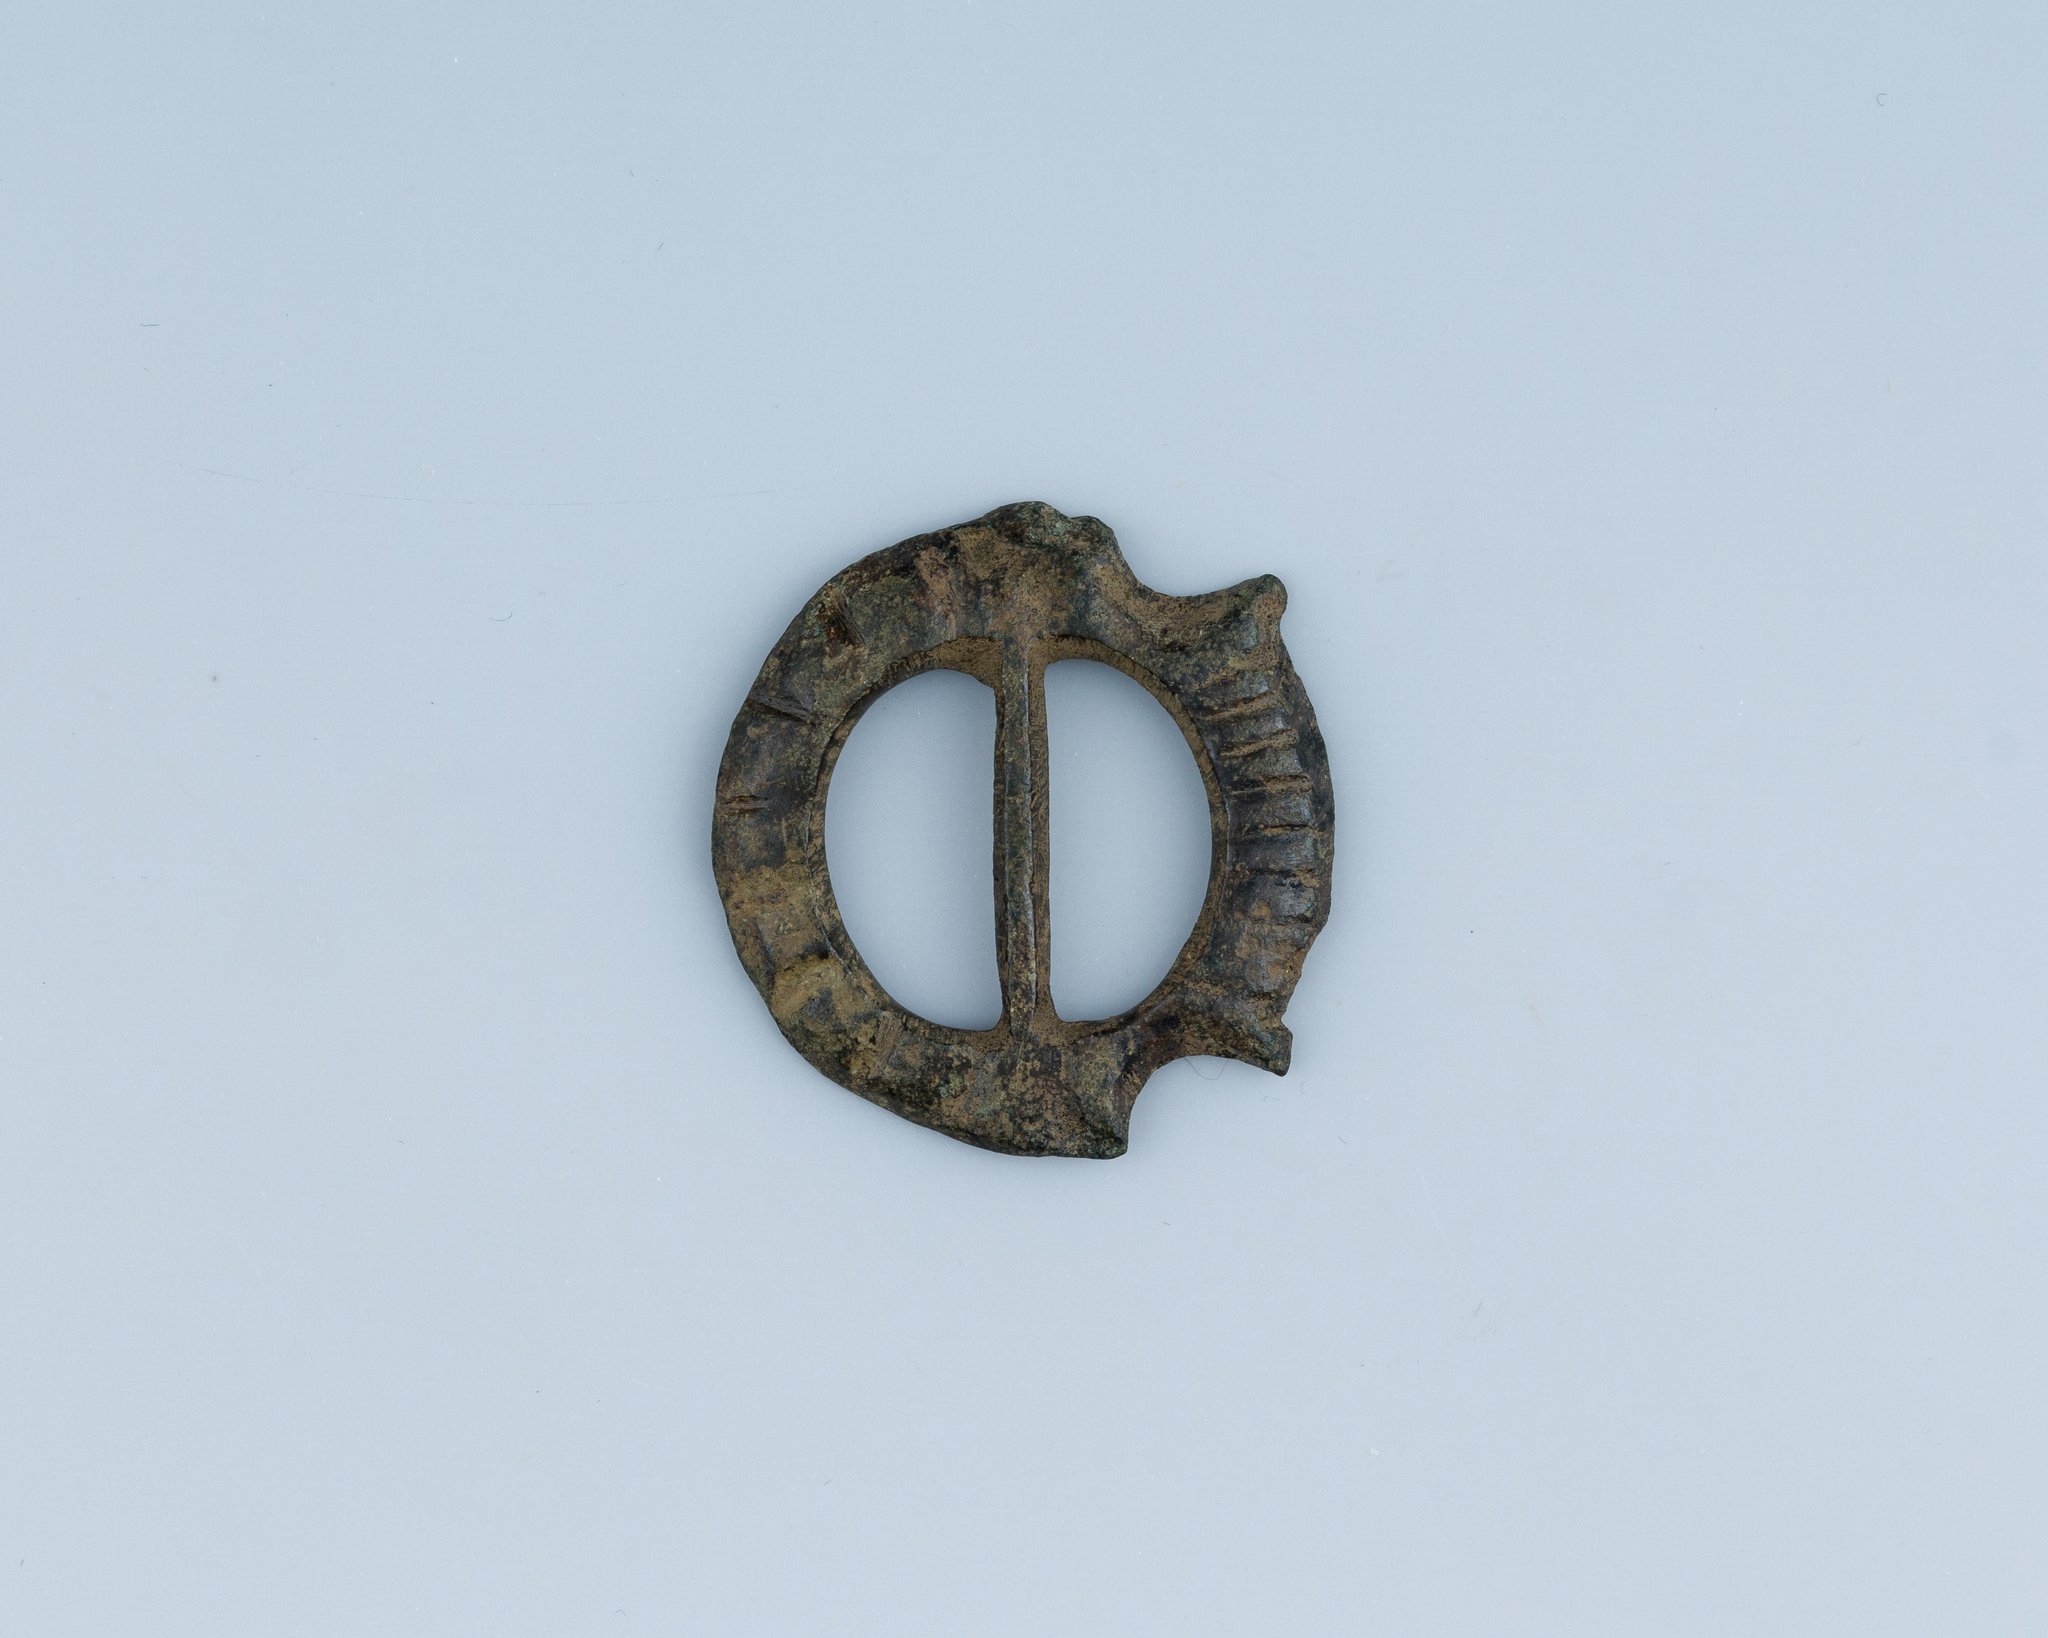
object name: buckle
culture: european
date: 1401-1600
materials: bronze